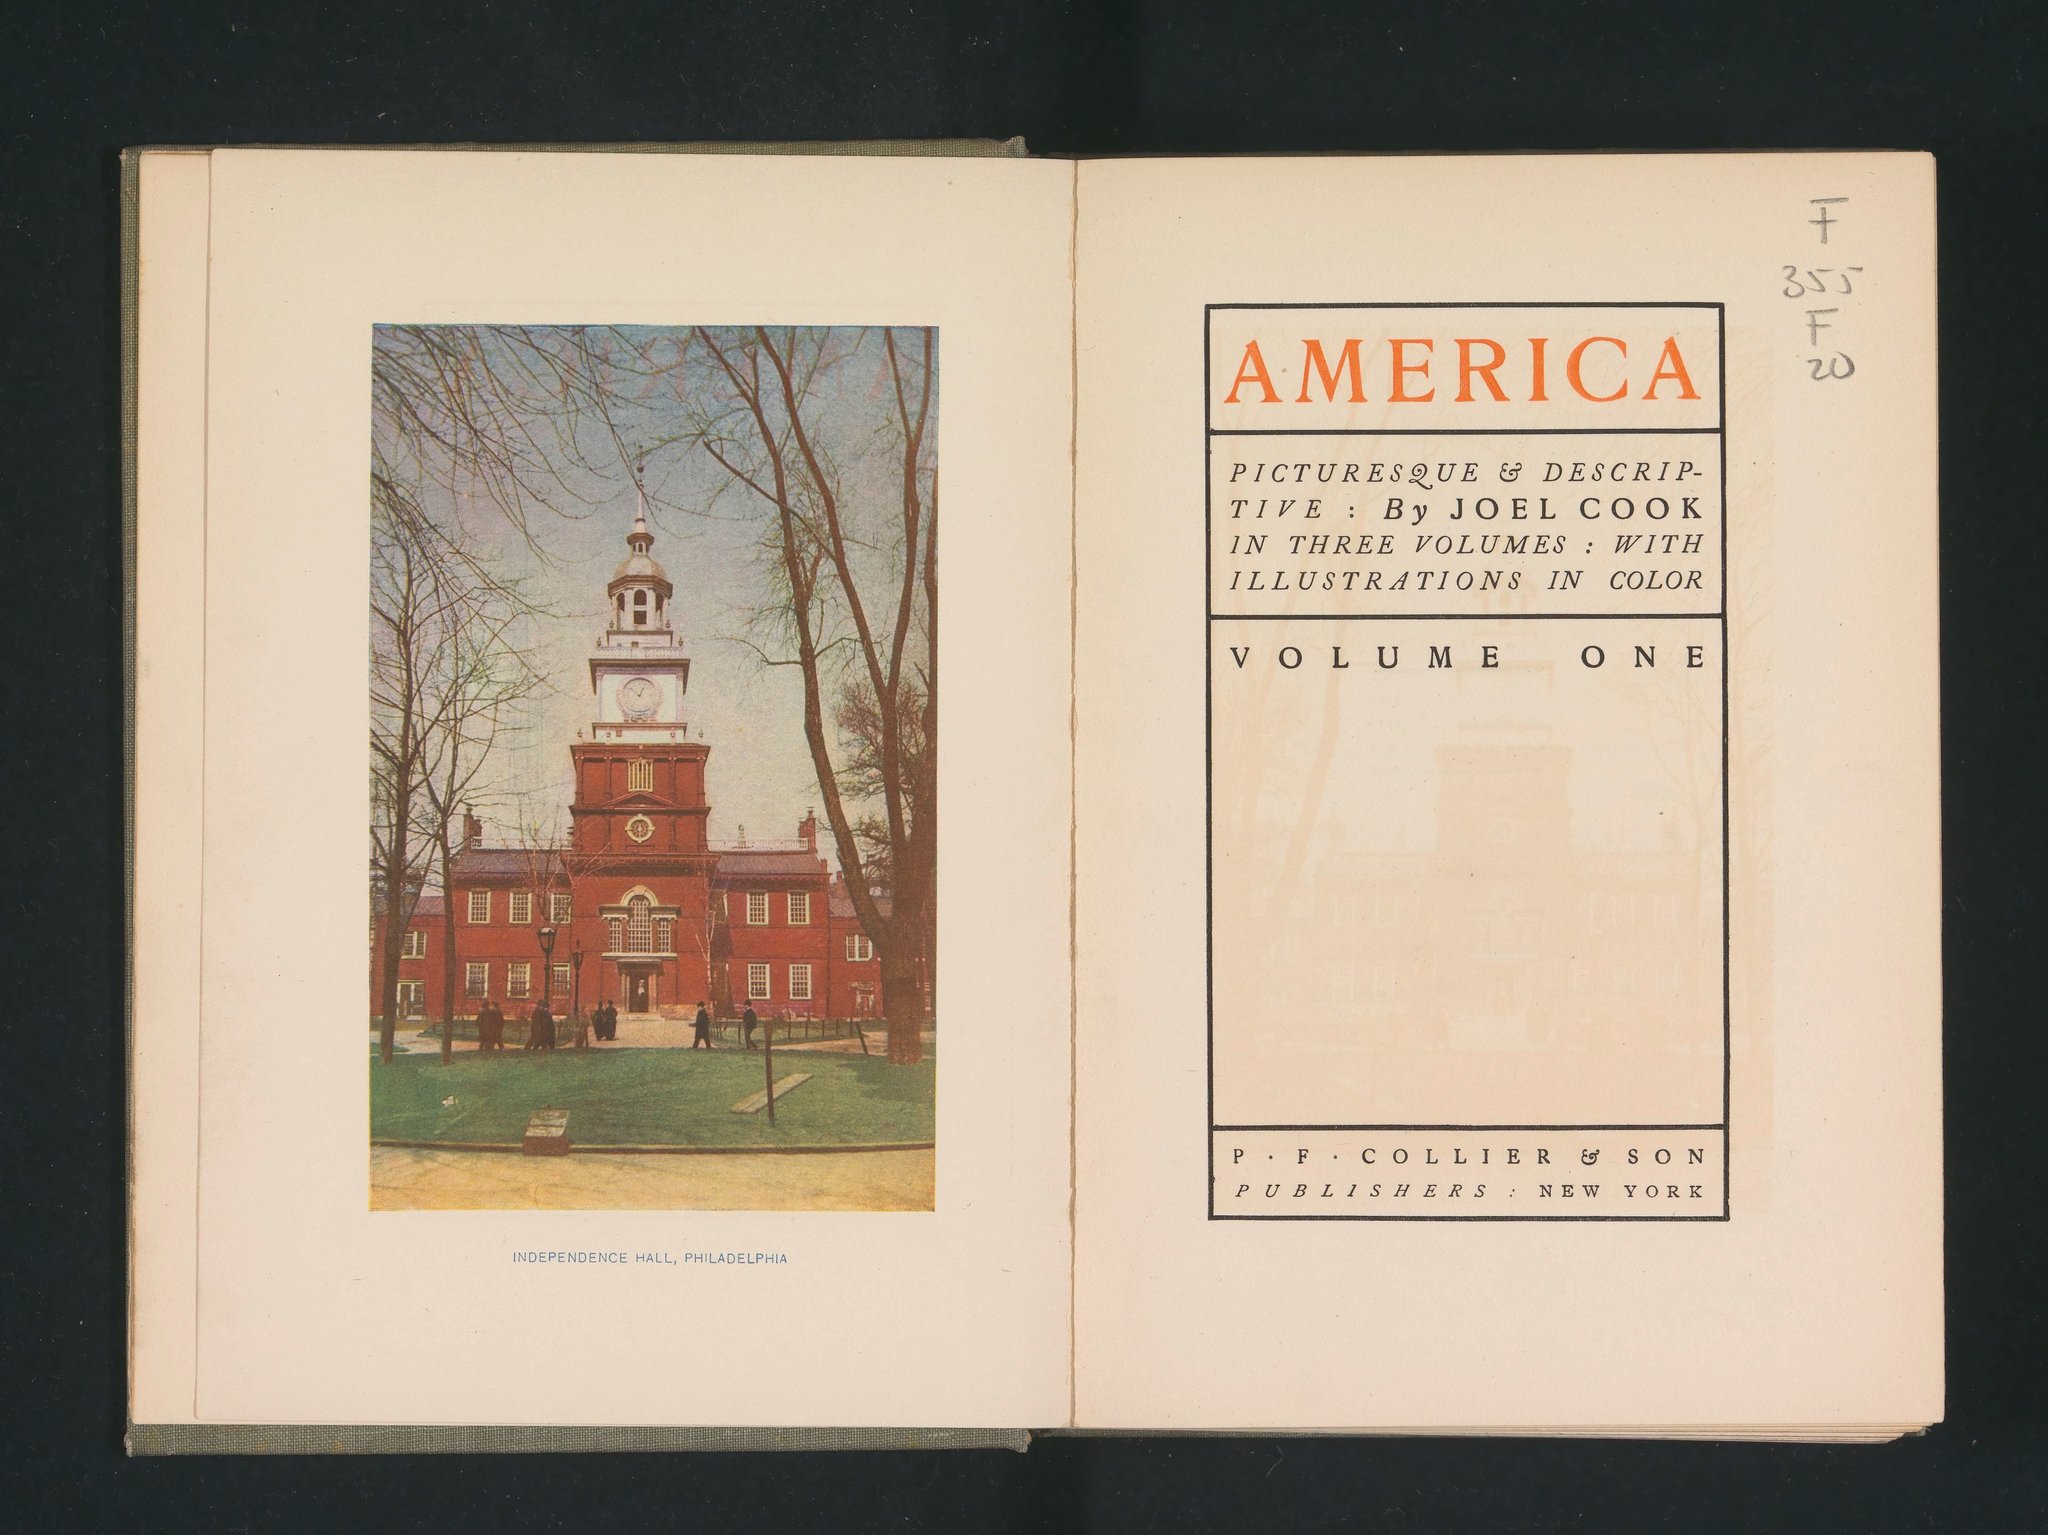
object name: book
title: America : picturesque and descriptive volume one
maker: joel cook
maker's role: politician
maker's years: 1842-1910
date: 1900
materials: cardboard, linen, paper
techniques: printing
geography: new york city